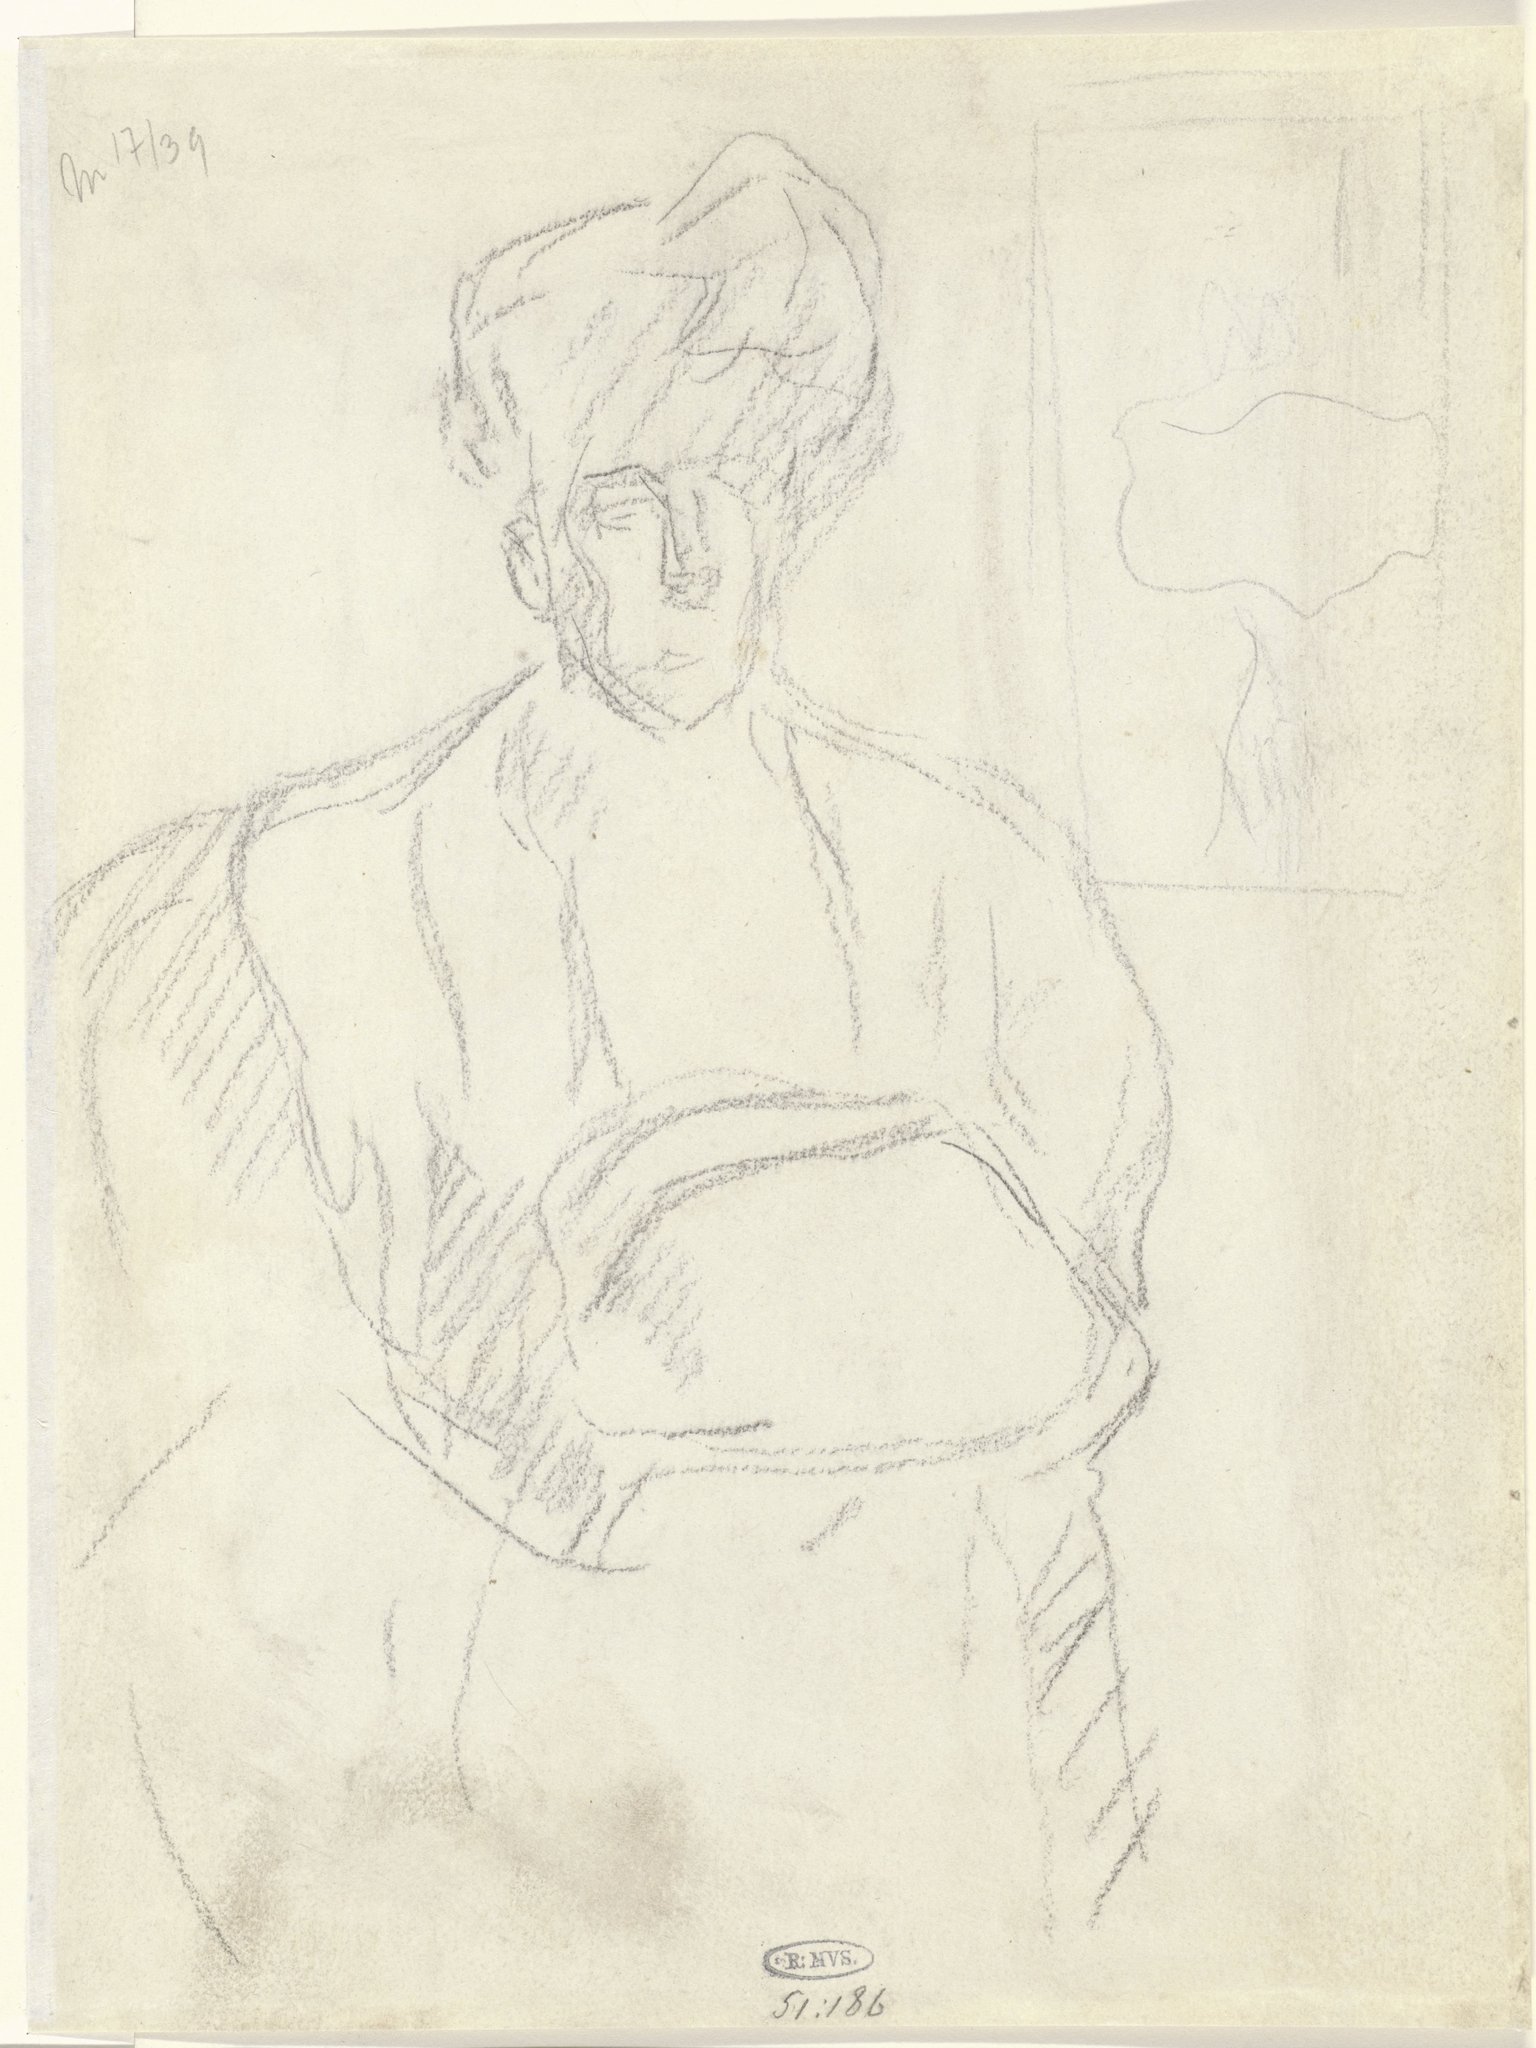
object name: drawing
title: Schets van een zittend figuur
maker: hendrik johannes haverman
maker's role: draughtsman, print maker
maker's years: 1857-1928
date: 1867-1928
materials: chalk, paper